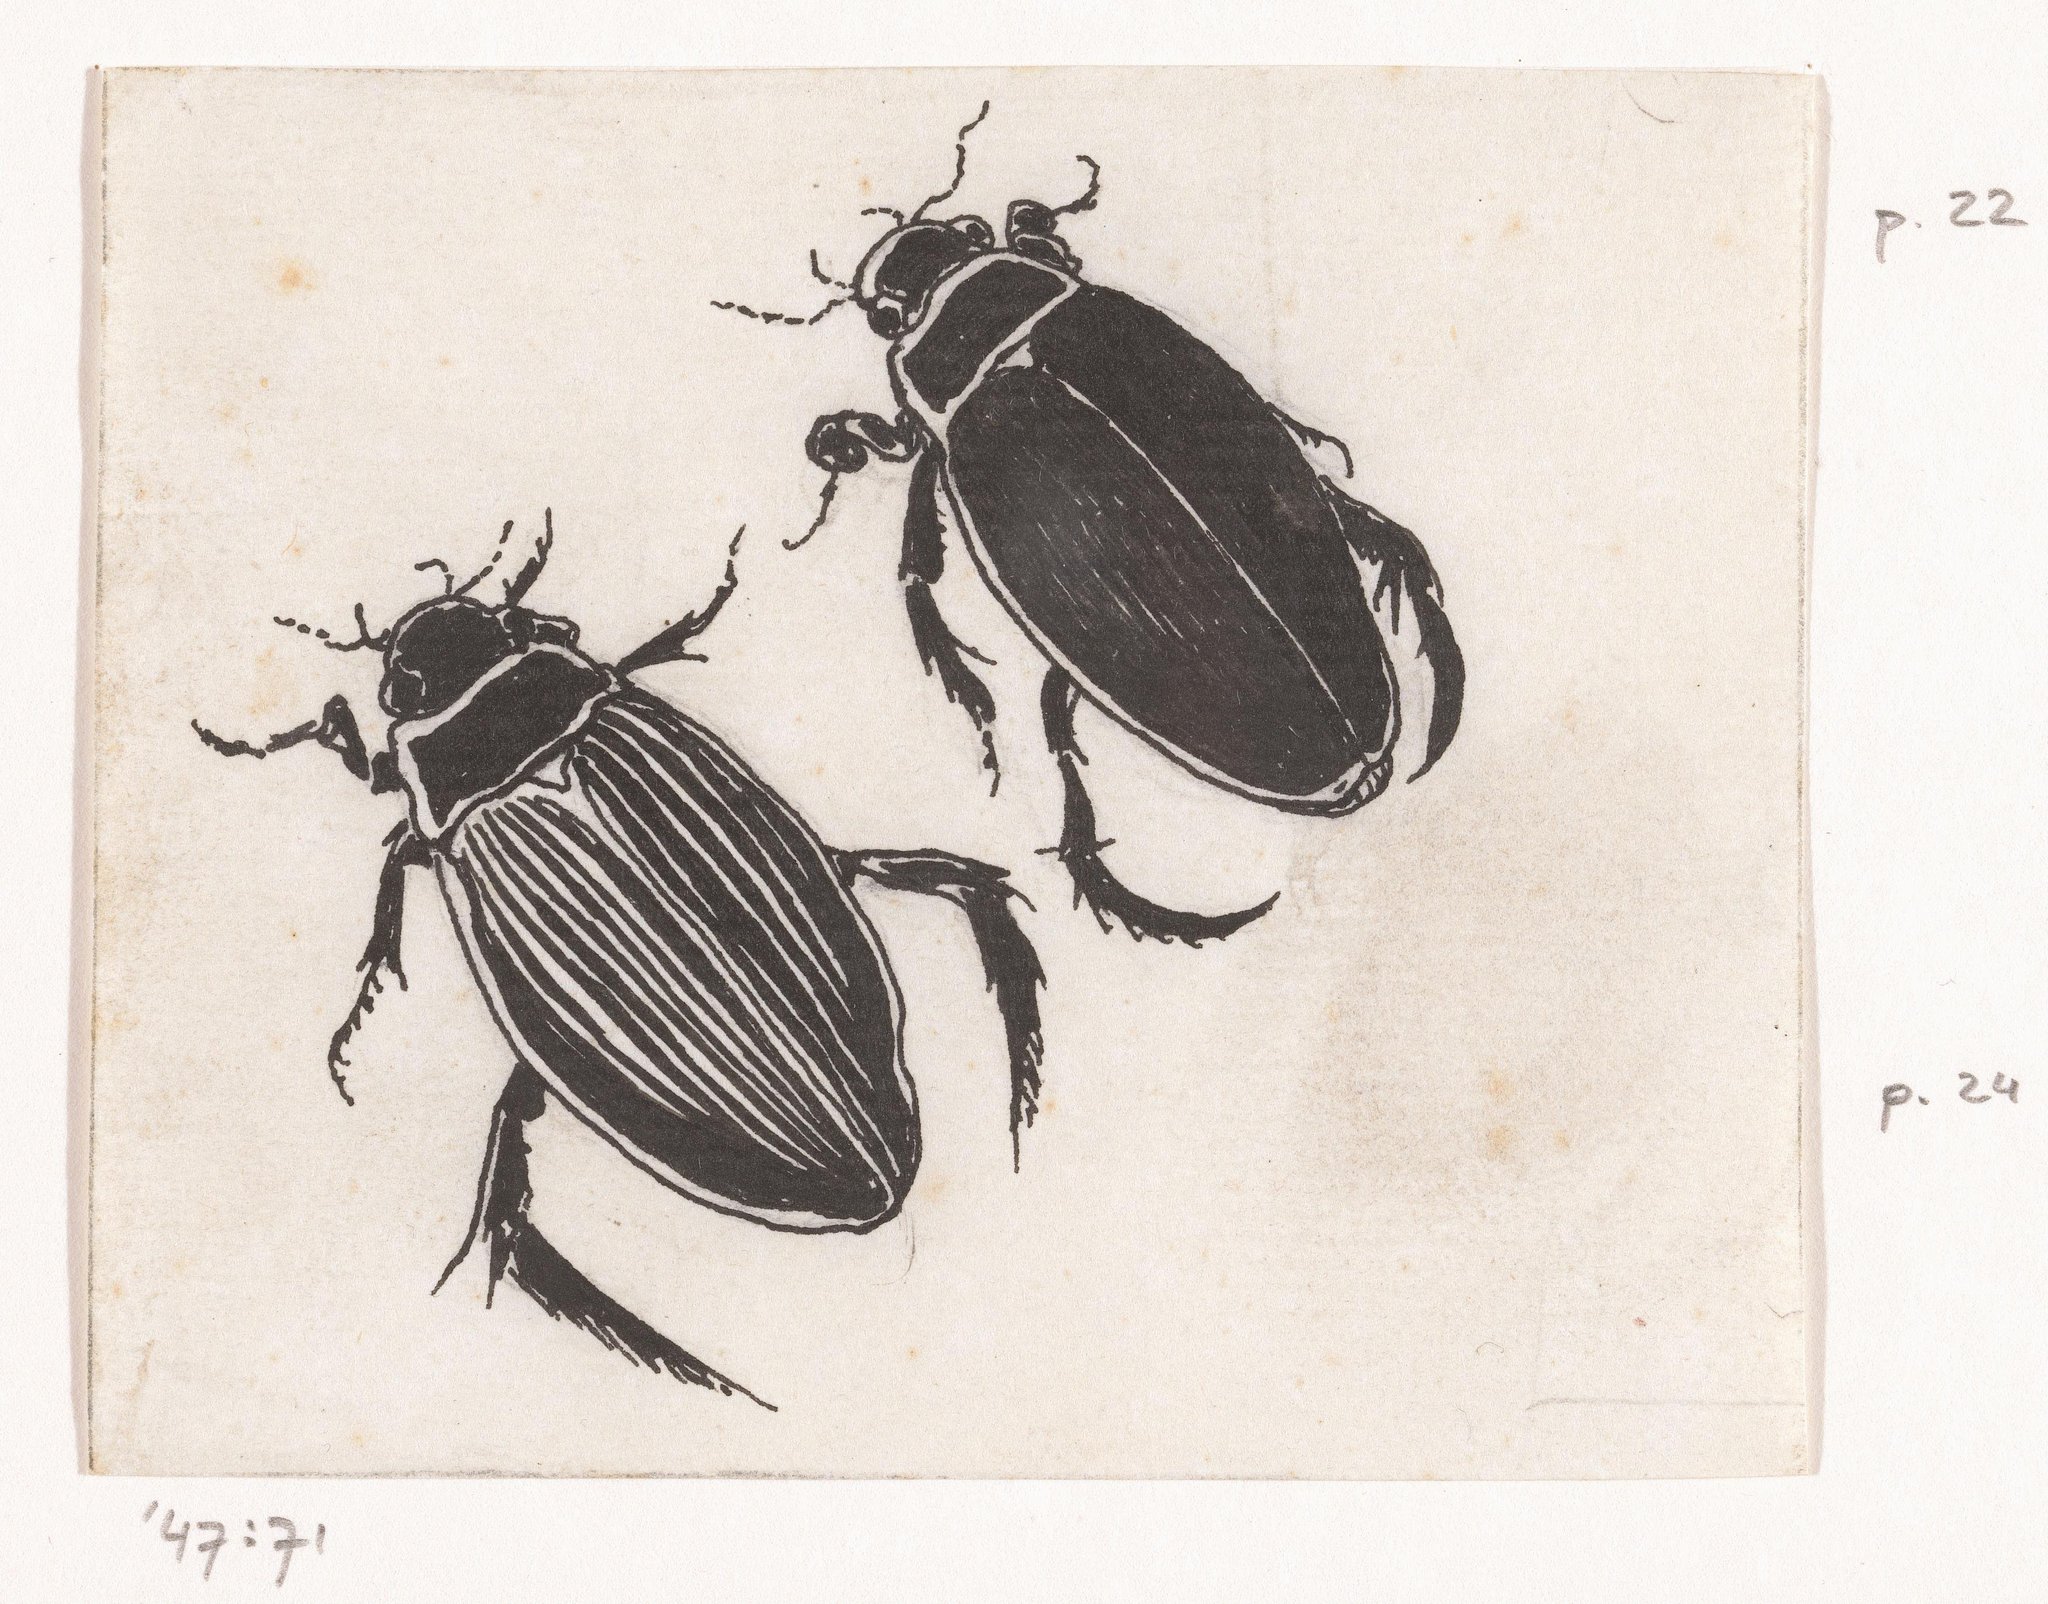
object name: drawing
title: Waterroofkevers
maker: willem wenckebach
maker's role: designer, draughtsman, painter, print maker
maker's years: 1860-1937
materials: ink, paper, pencil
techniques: pen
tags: insects: beetle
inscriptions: collector's mark: Lugt 2228a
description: Ontwerp voor: Knappert, Emilie C. Kijkjes in de plantenwereld. Loman & Funke: Amsterdam, 1893.